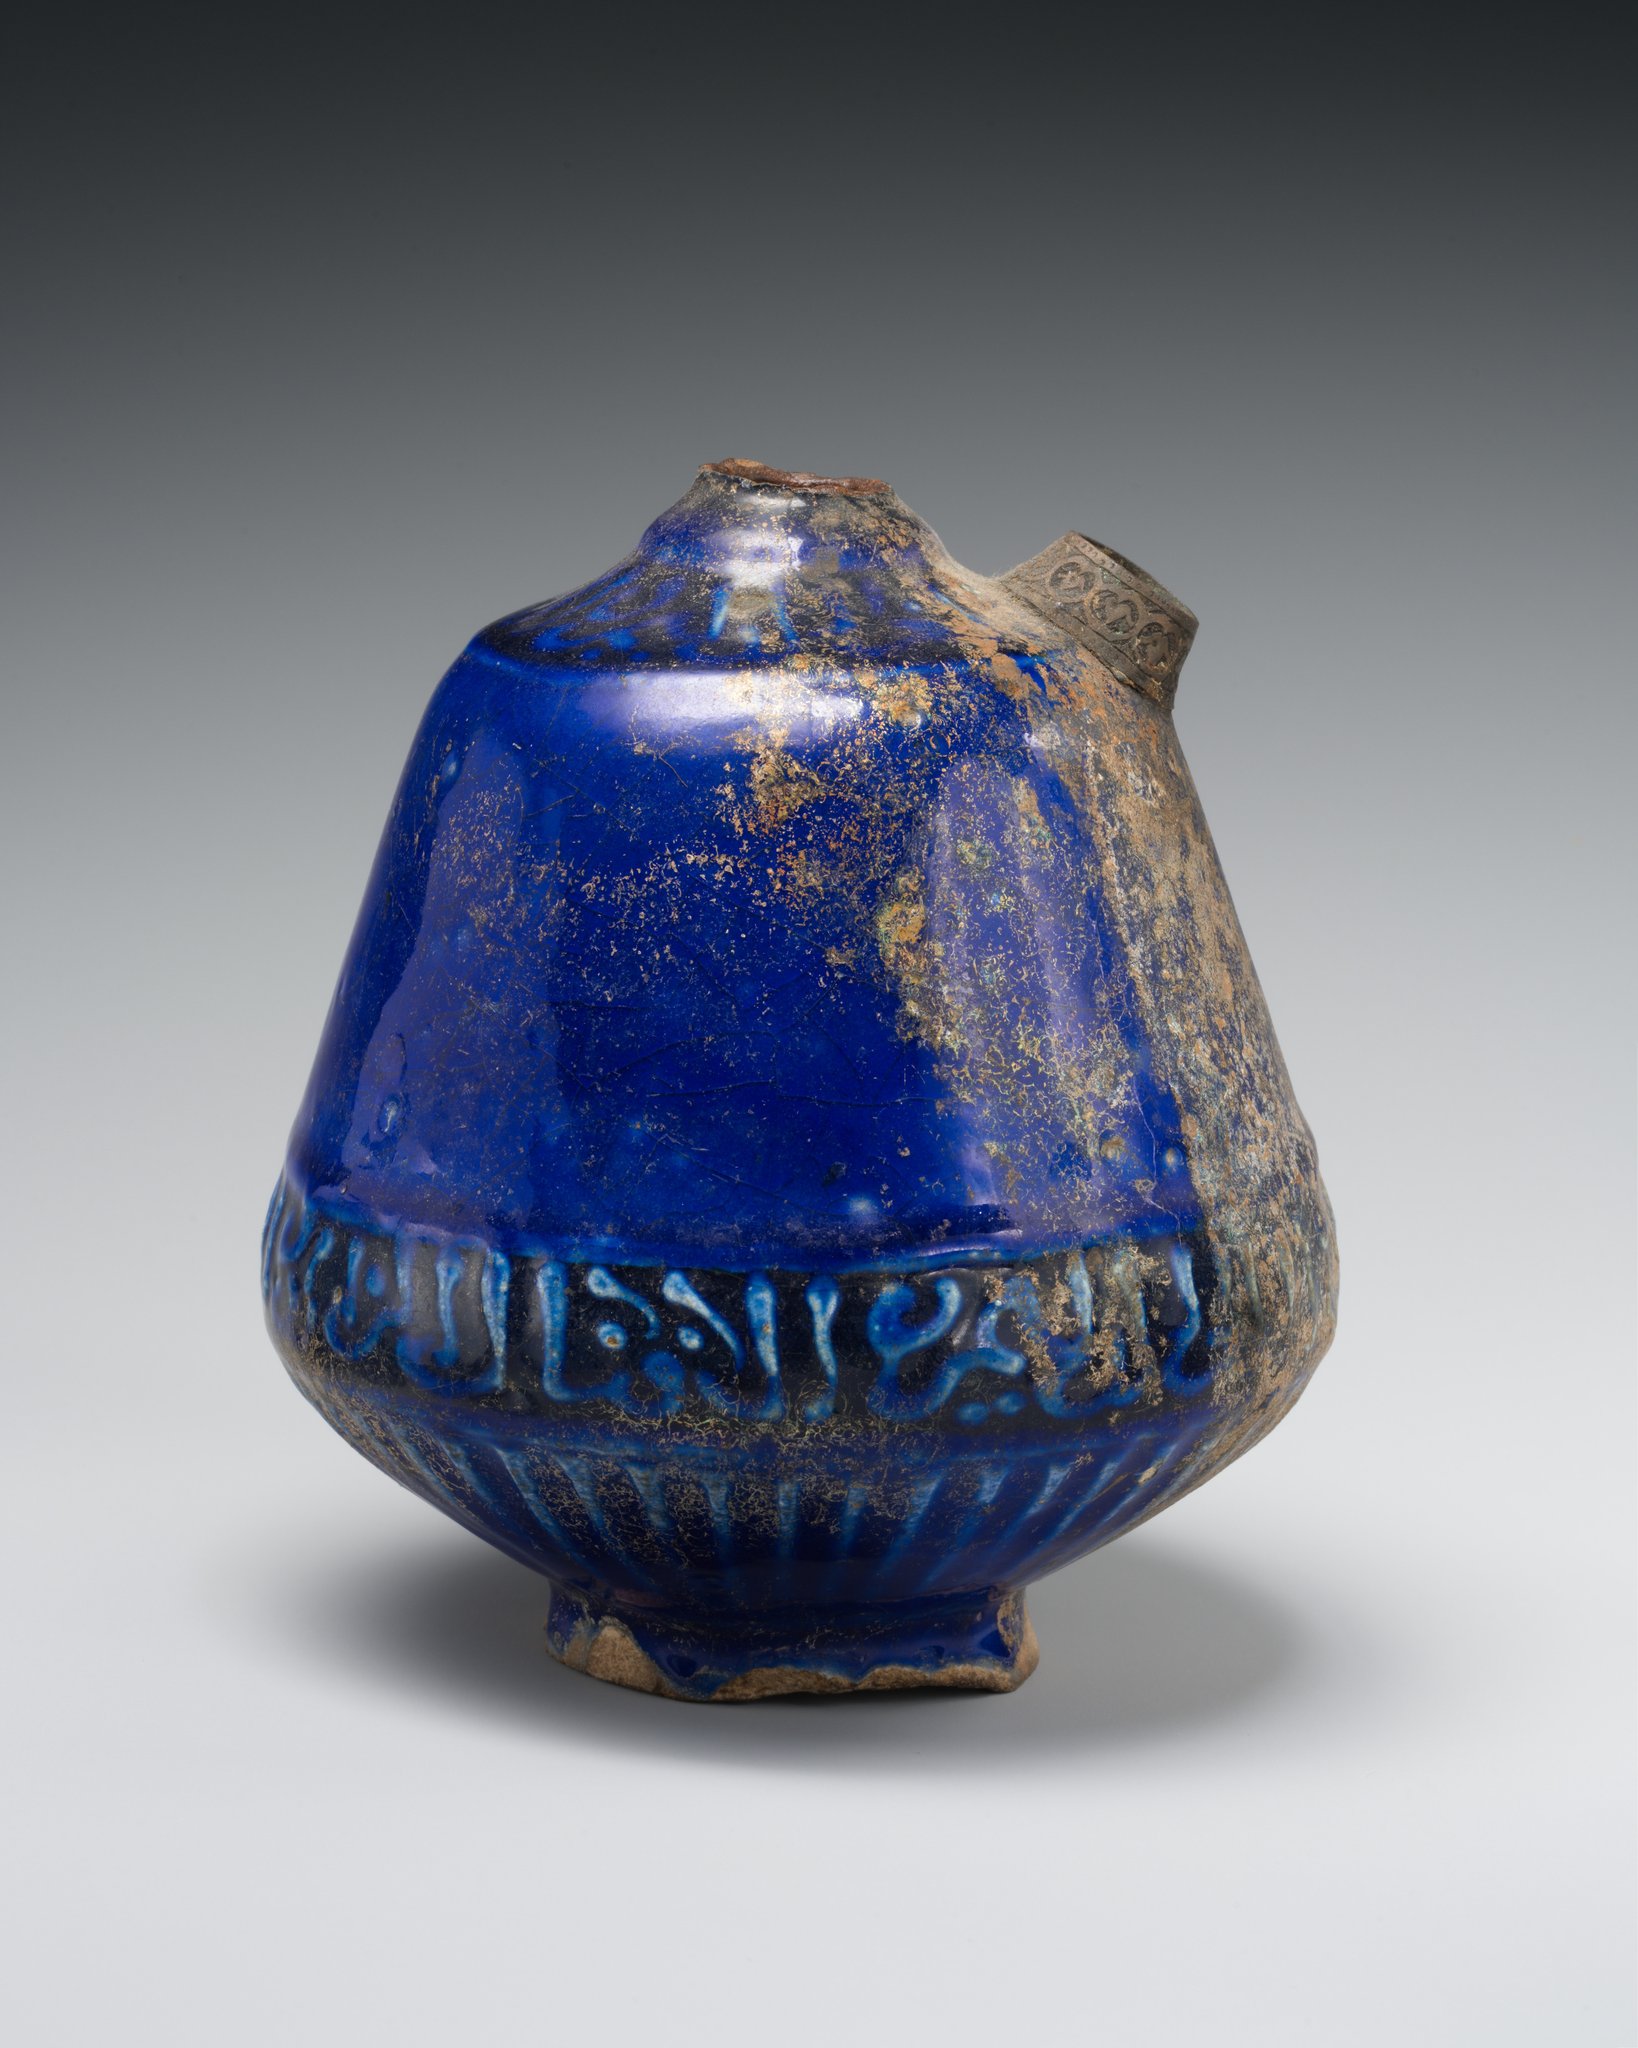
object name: ewer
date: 1301-1400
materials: stonepaste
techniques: glazing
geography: iran